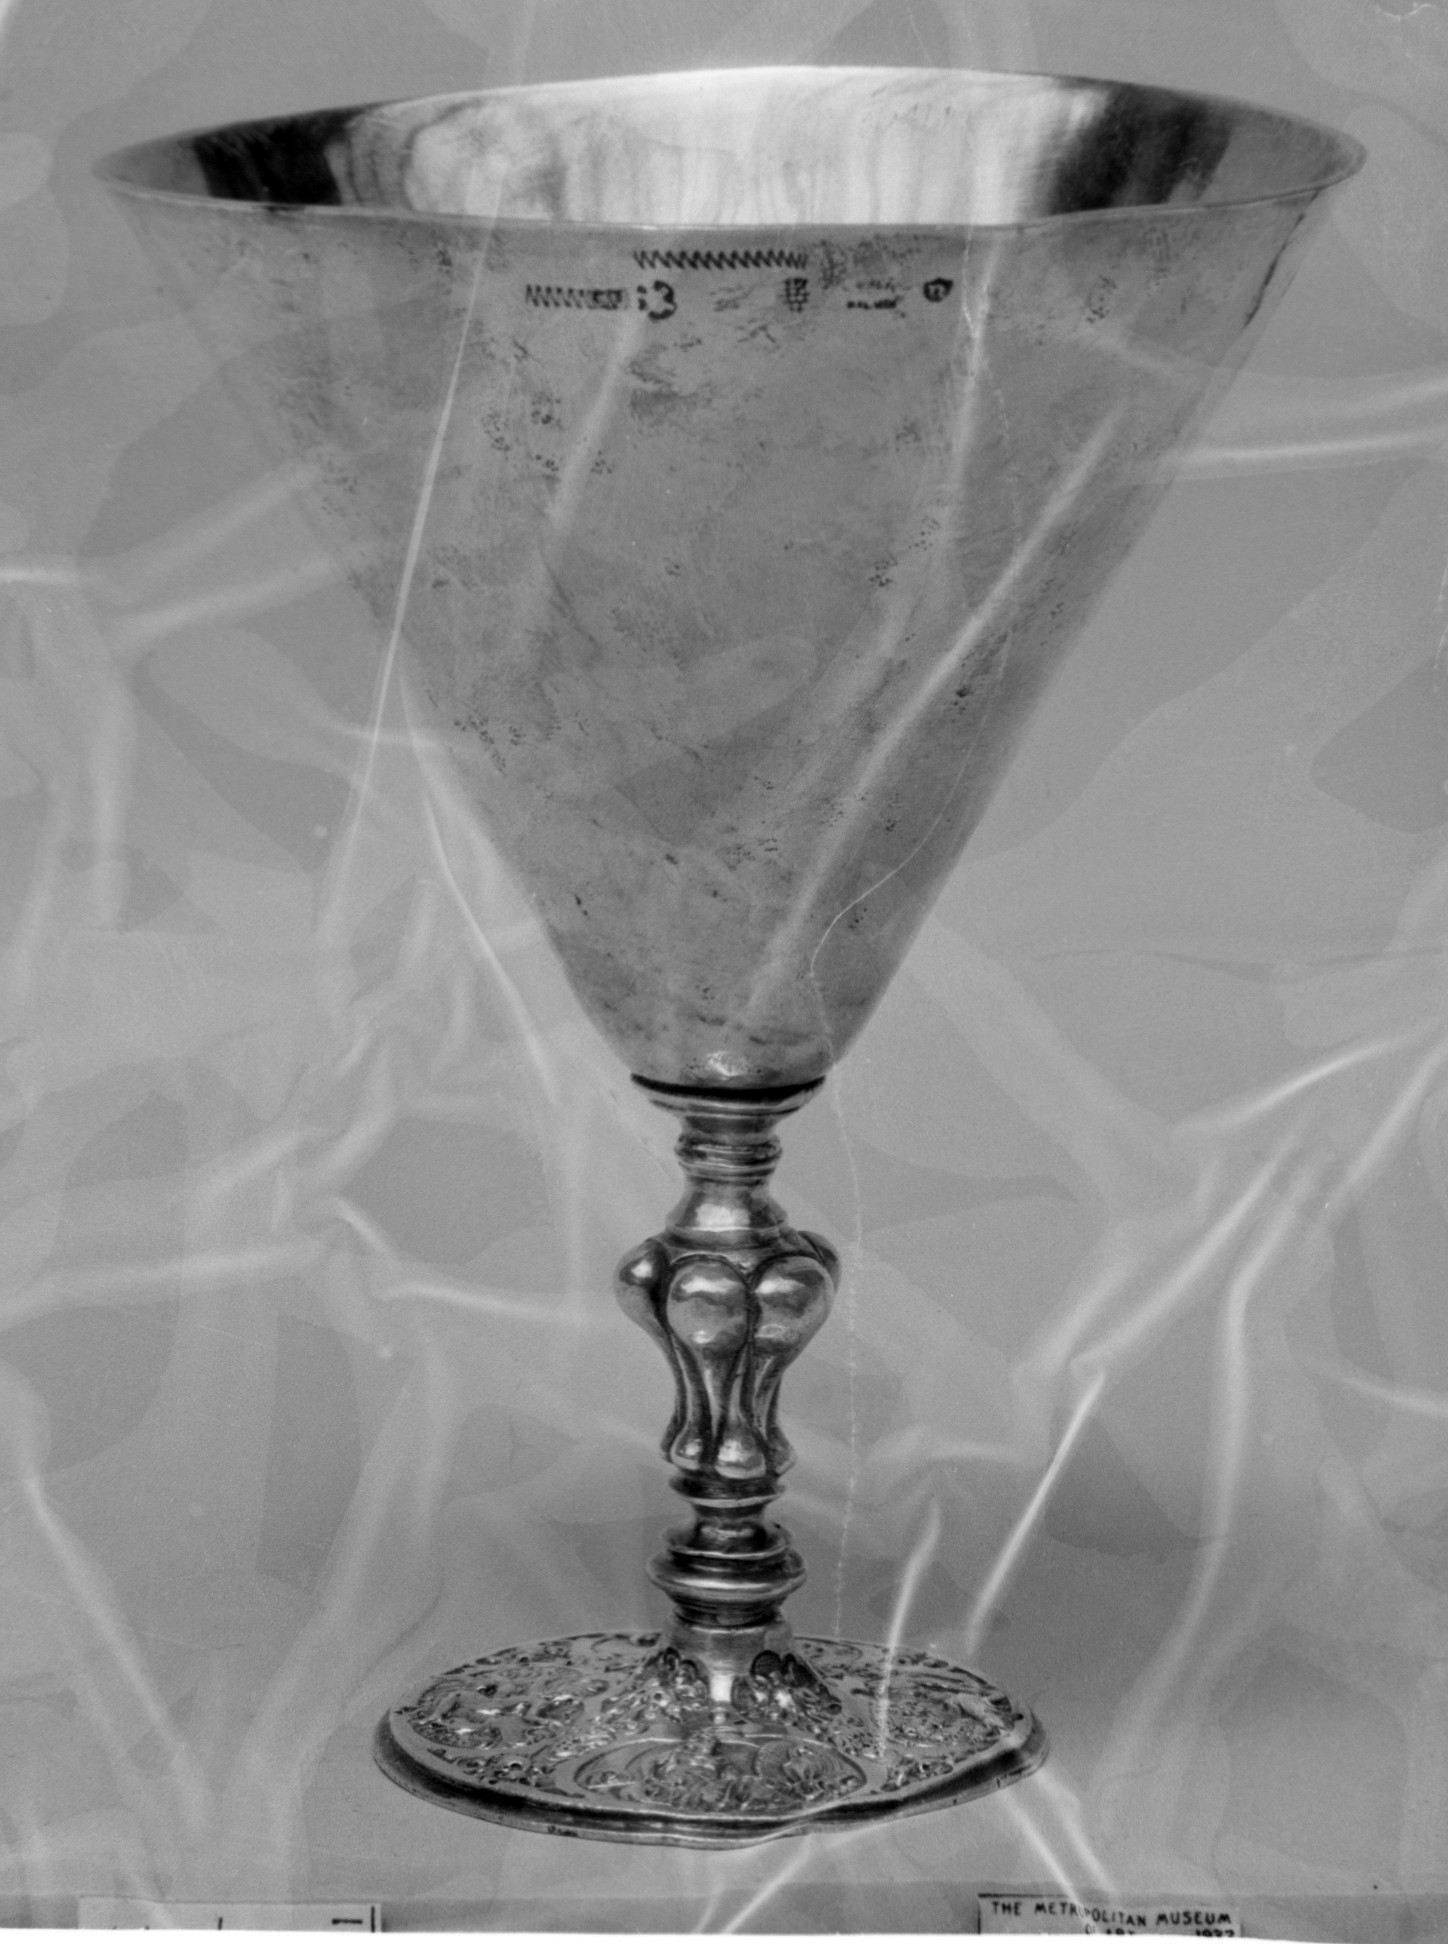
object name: goblet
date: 1567-1633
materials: silver gilt